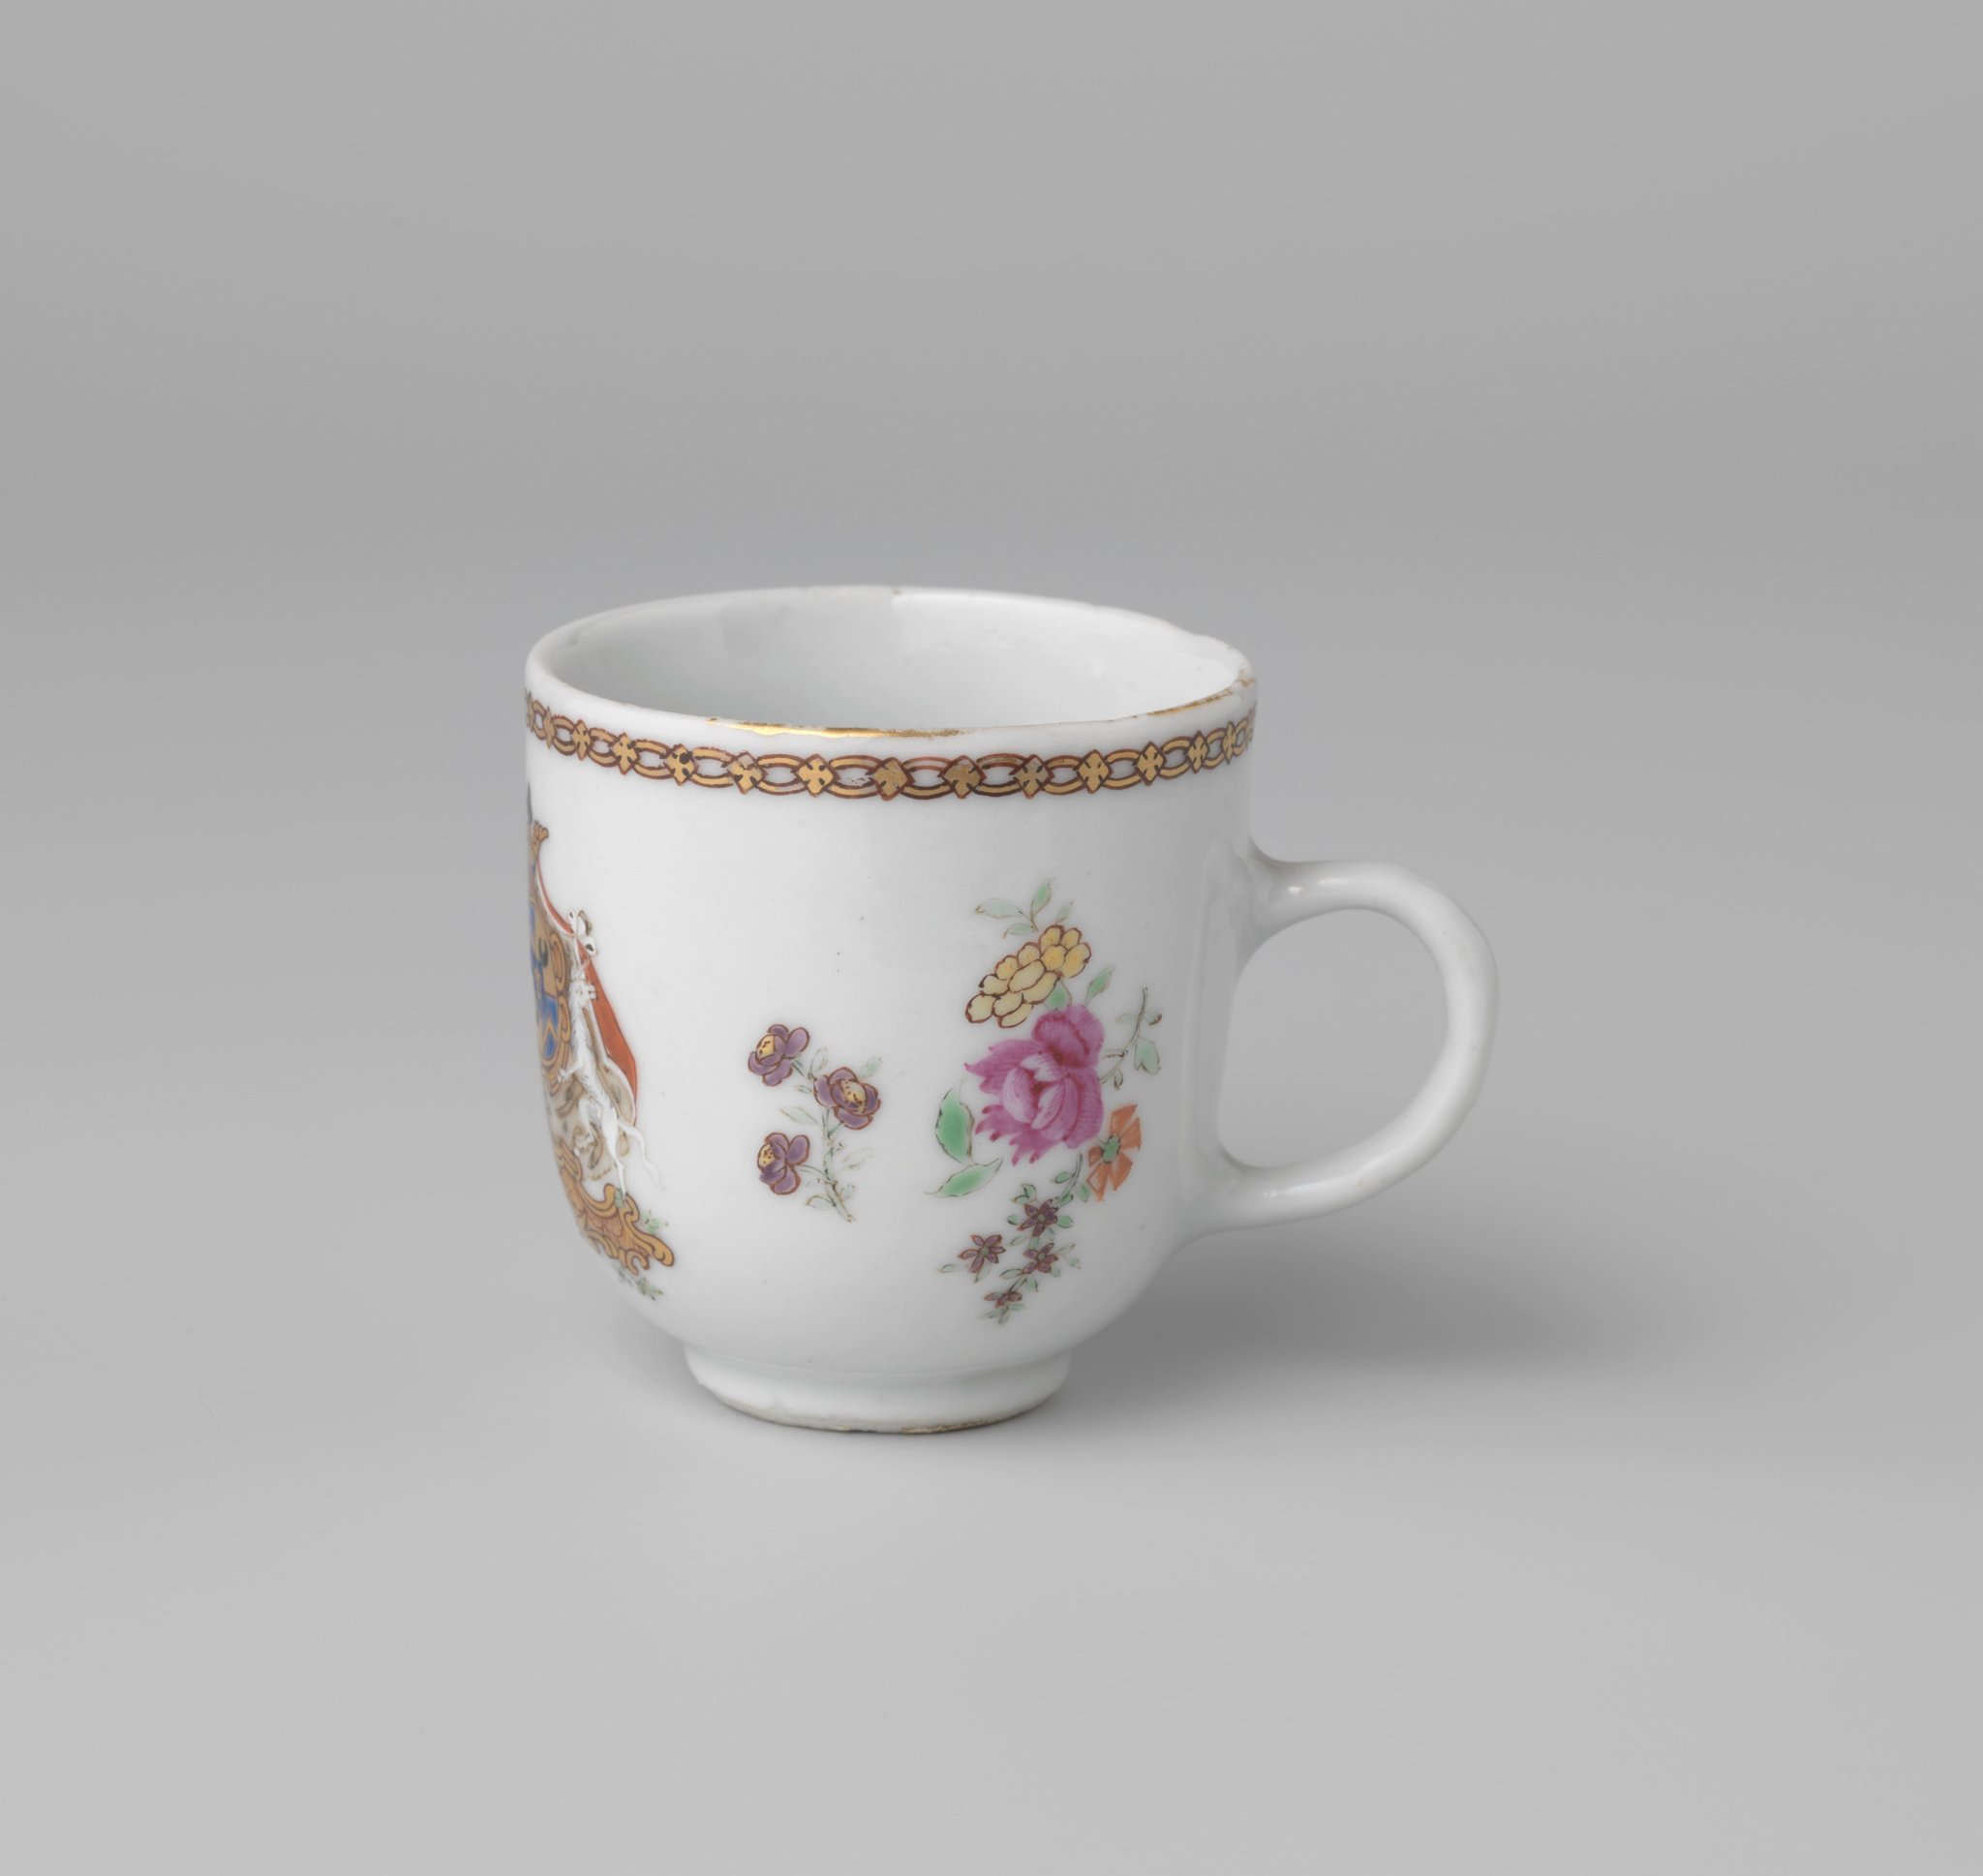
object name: cup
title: Cup with the arms of the Van Idsinga and Kien families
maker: Anonymous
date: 1750-1774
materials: glaze, gold, paint, porcelain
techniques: firing, gilding, turning, vitrification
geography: china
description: Oorkop van porselein, beschilderd op het glazuur in blauw, rood, roze, groen, geel, paars, zwart en goud. Op de wand het alliantiewapen van de families Van Idsinga en Kien. Het wapen links van de familie Van Idsinga heeft een blauwe achtergrond met een zilveren roos of bloem en een paar gouden klavers. Het wapen rechts van de familie Kien is verdeeld in vier delen: 1. en 4. een blauwe achtergrond met een gouden keper, 2. en 3. een gouden achtergrond met een zwarte maan. In het midden van het wapen is een hartschild met een blauwe achtergrond en een gouden fleur-de-lis. Bovenop de wapens is een kroon afgebeeld. De wapens zijn afgebeeld op een gouden cartouche met schelp- en bladwerk in Louis XIV-stijl. Daarachter een hermelijnen mantel in rood en wit. Het geheel wordt ondersteund door twee eenhoorns die staan op een voetstuk. Op de wand strooibloemen; de rand met een schakelpatroon. Wapenporselein met emailkleuren.